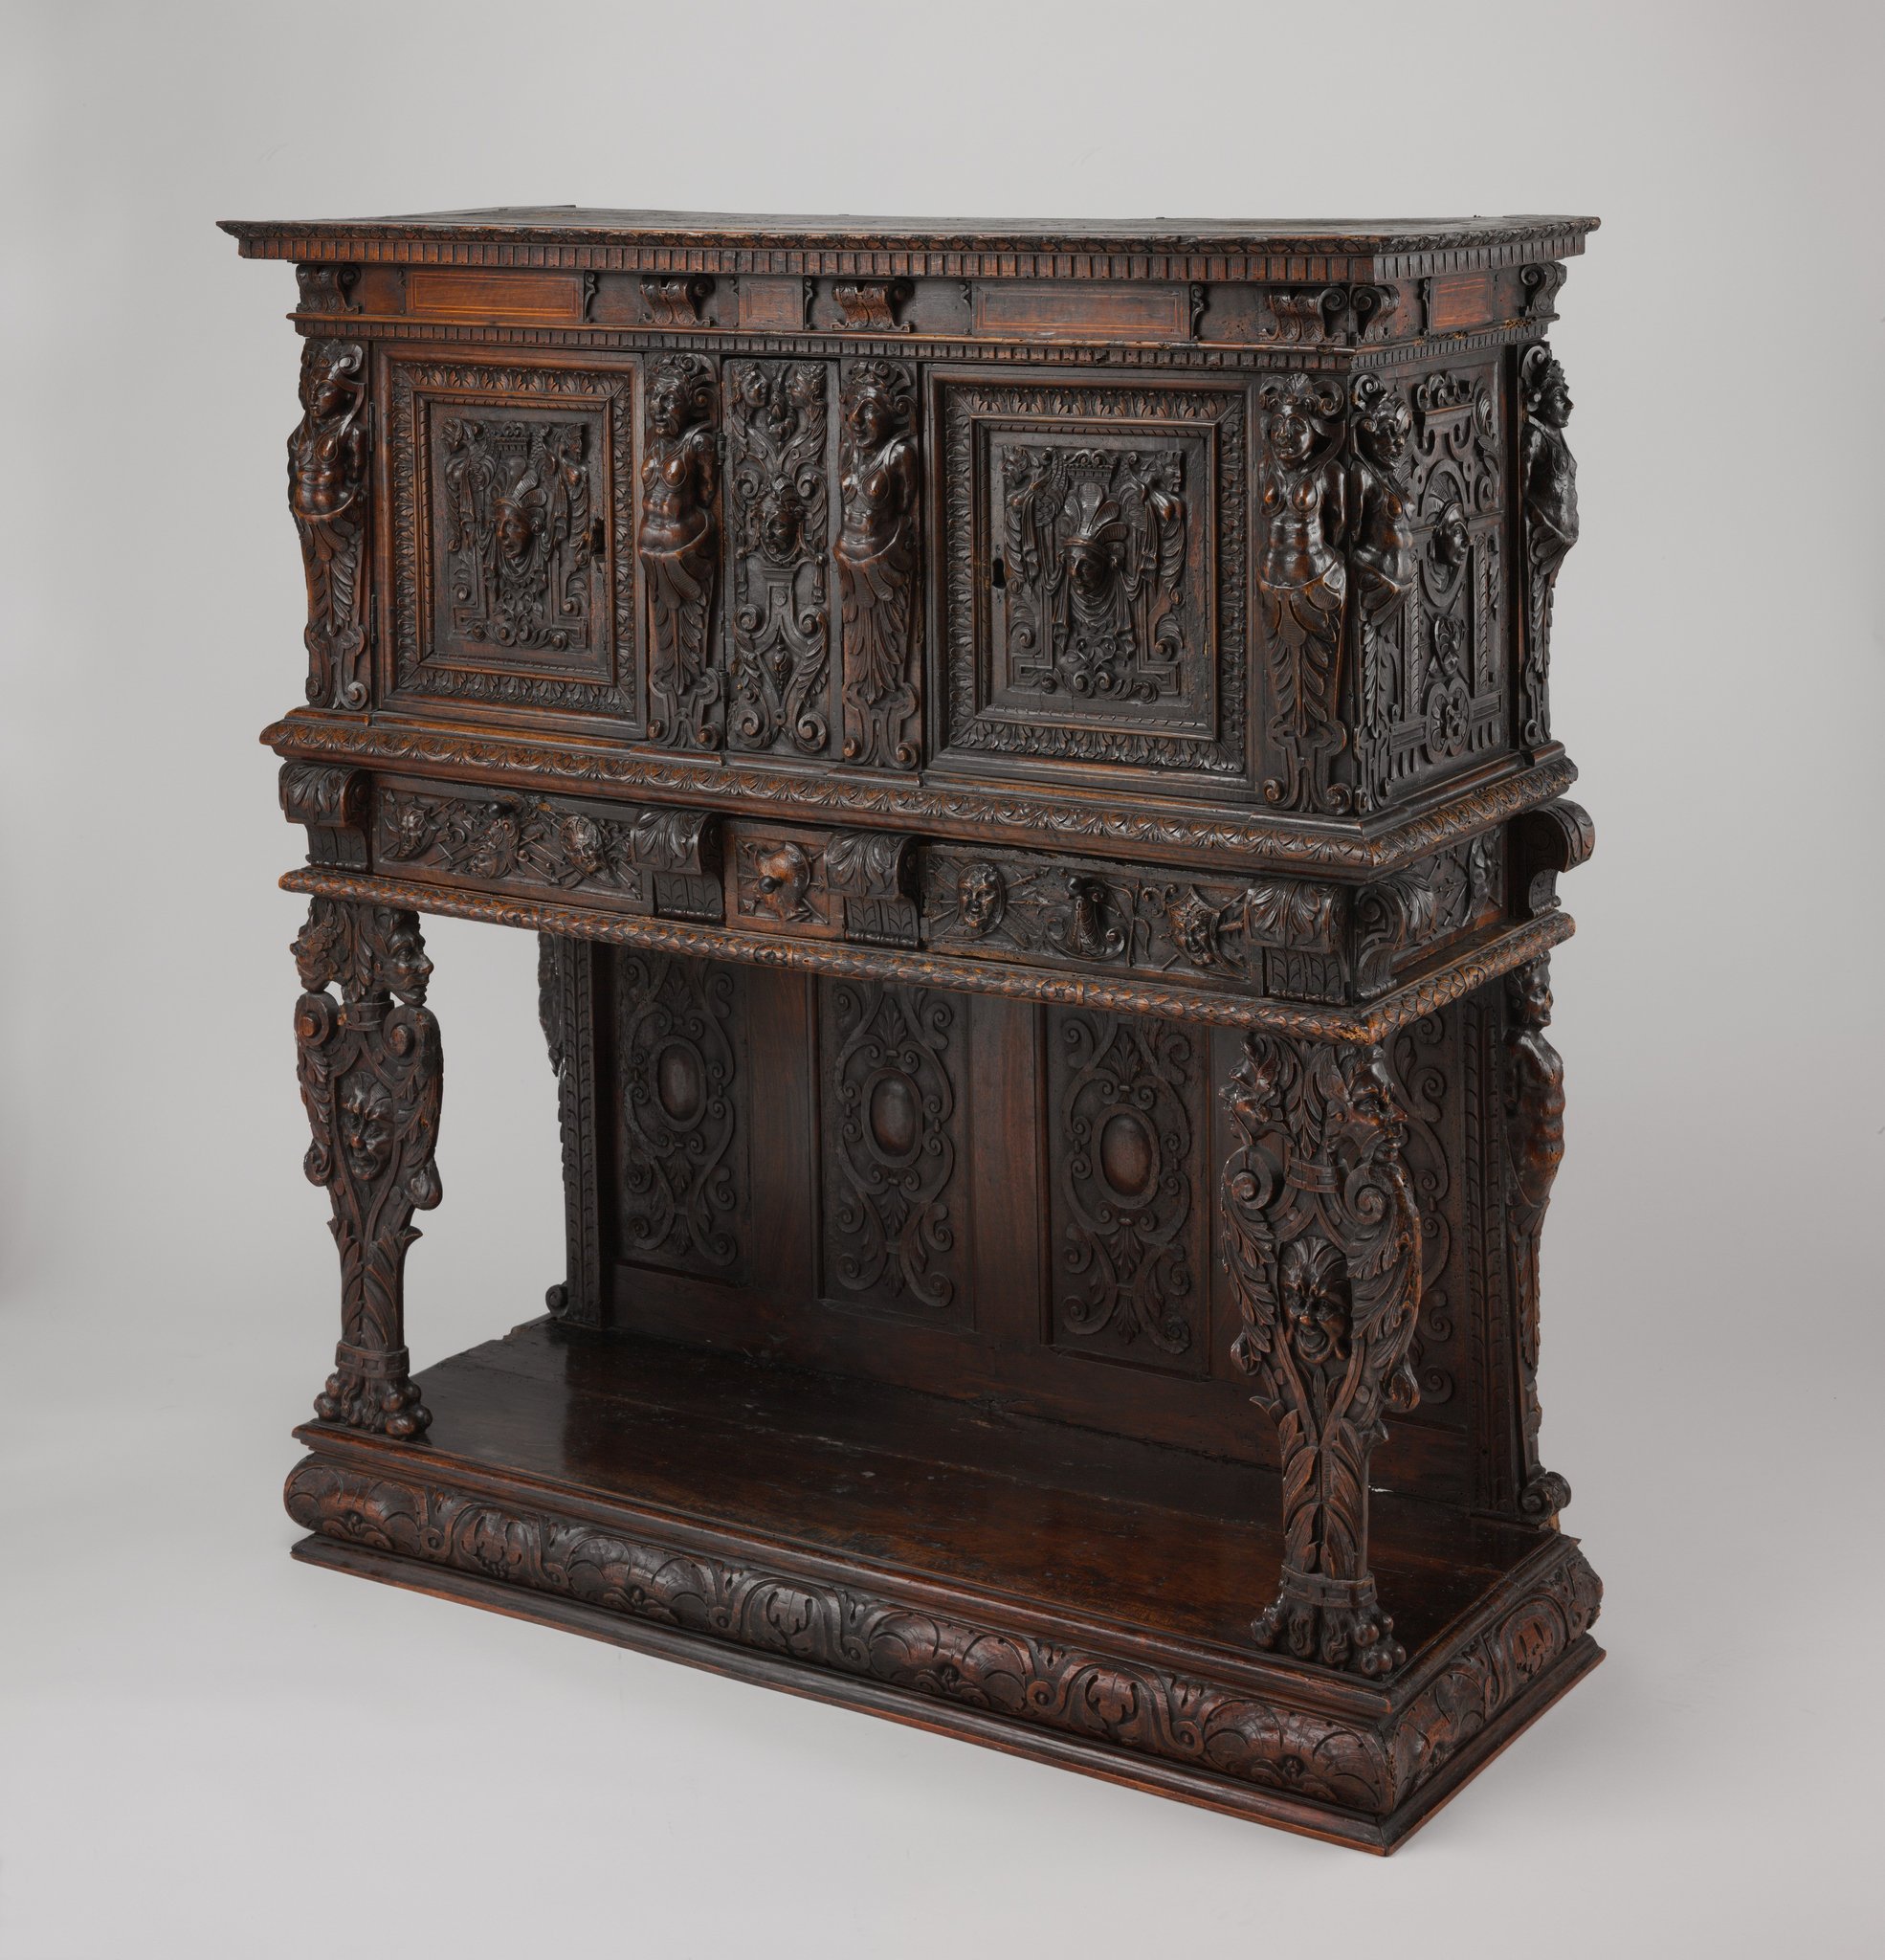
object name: dresser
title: Dresser (Dressoir aux harpies)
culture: french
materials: iron, wood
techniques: carving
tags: masks,caryatids,grotesques